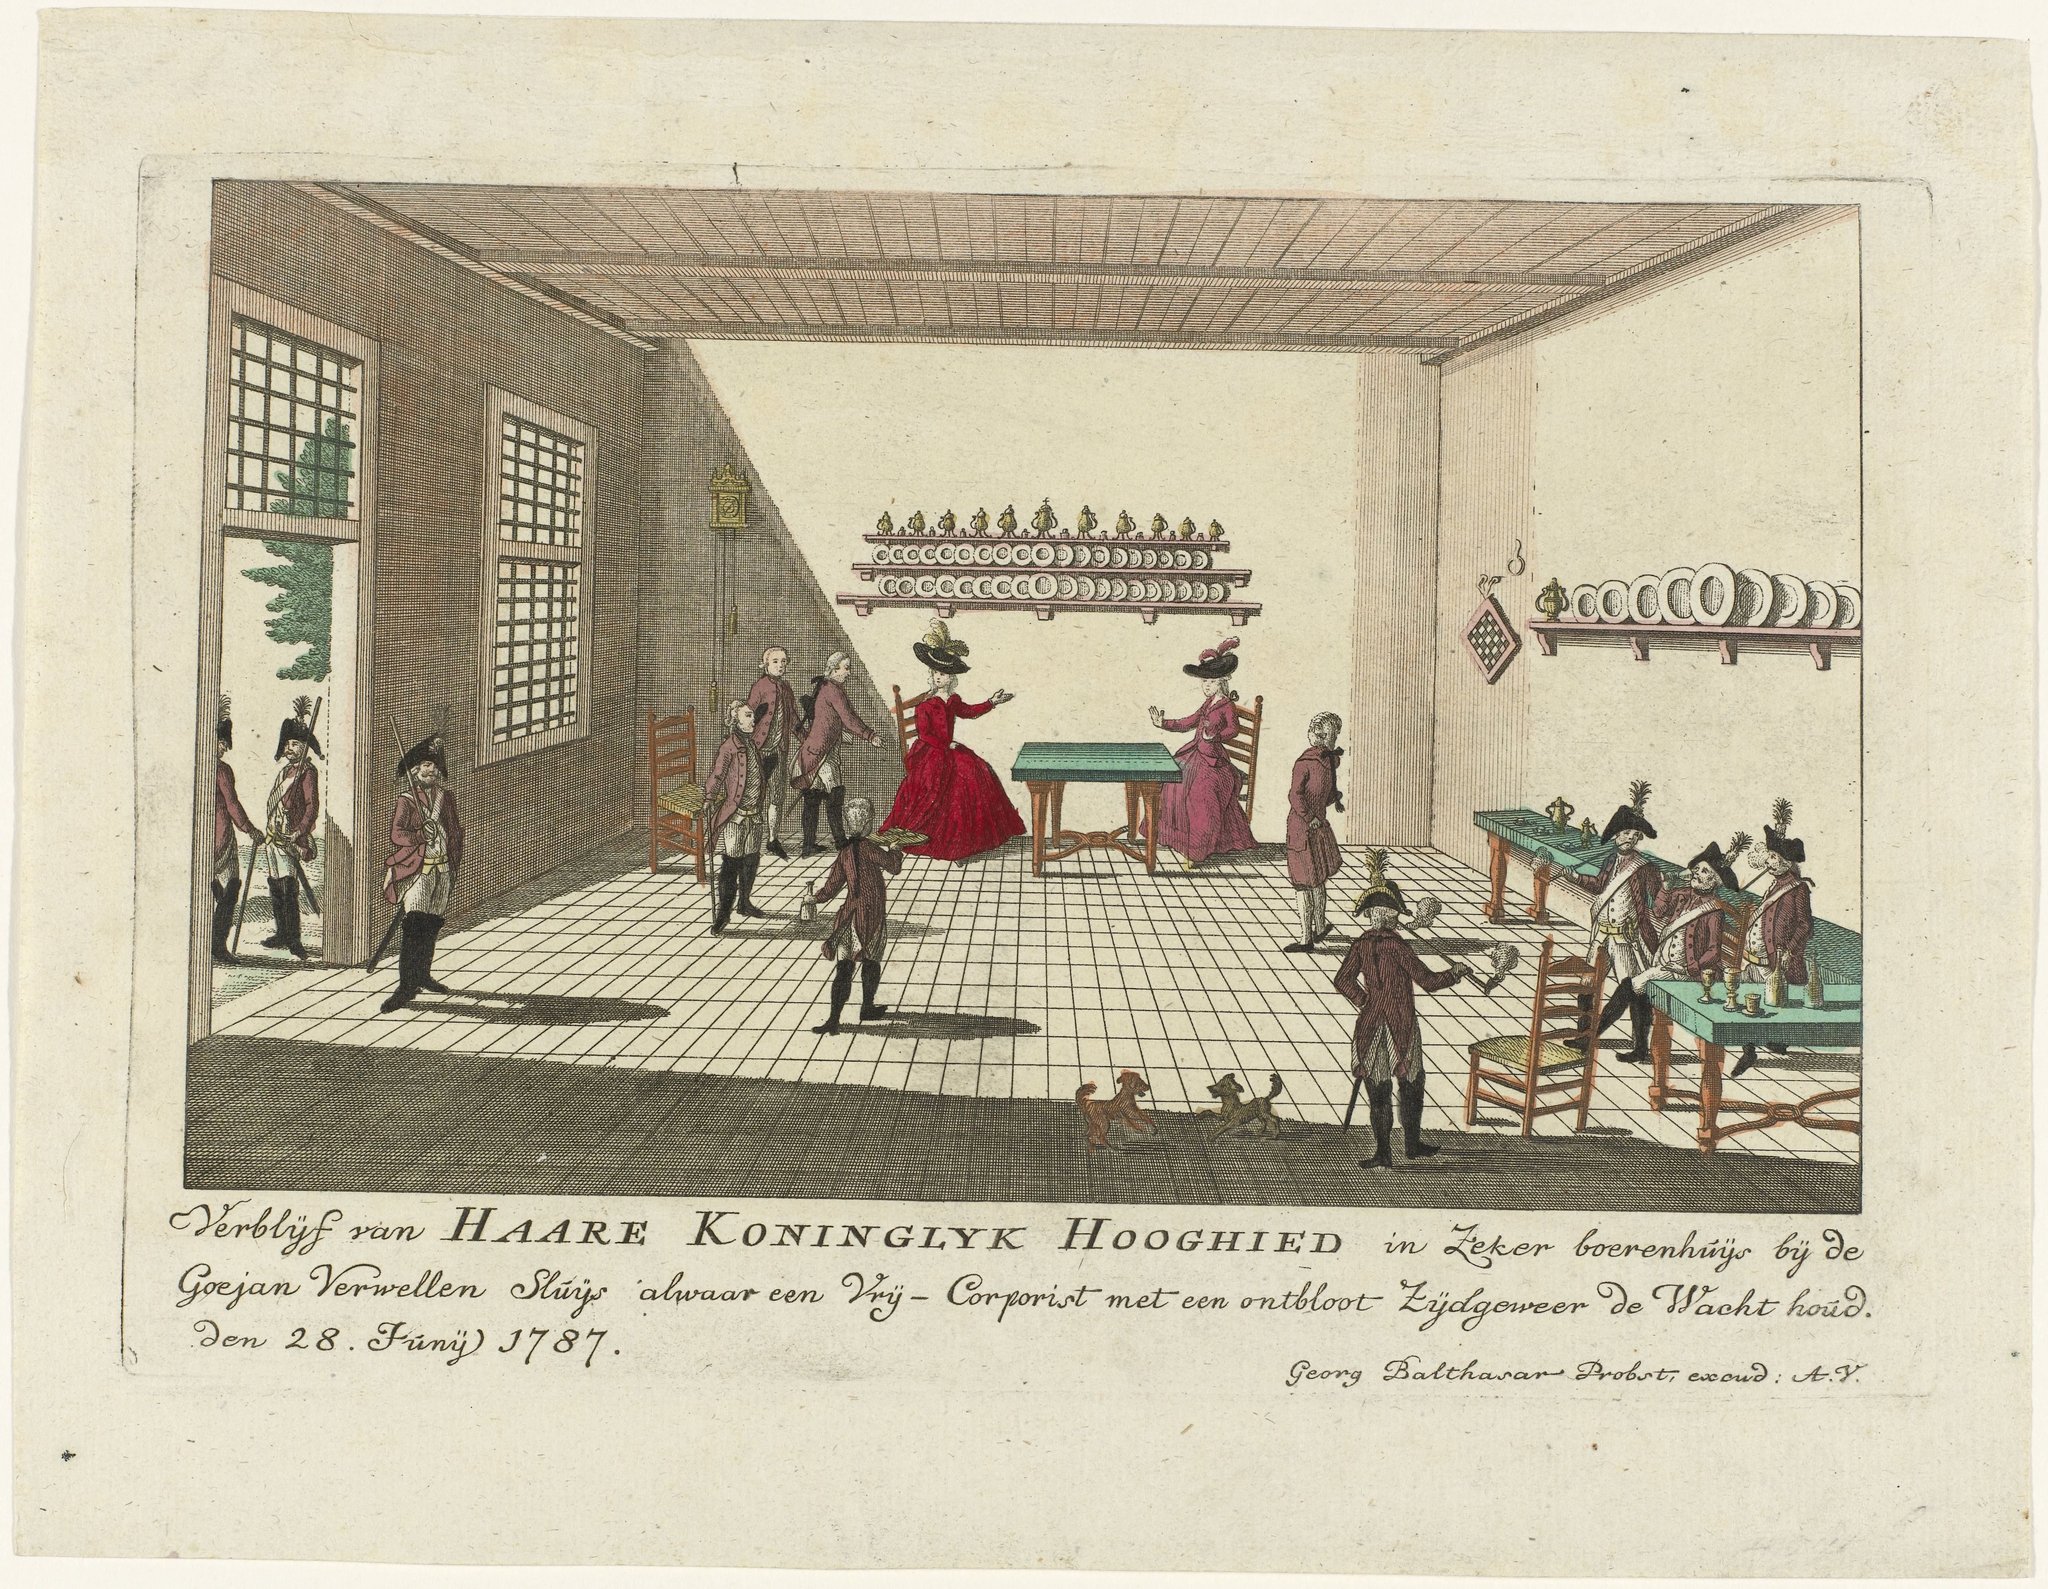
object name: print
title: Ingekleurde Duitse prenten over de gebeurtenissen van 1787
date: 1788-1790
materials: paper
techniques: engraving, etching, hand coloring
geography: augsburg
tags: painter, draughtsman, wilhelmina of prussia (princess of orange), arrest (of criminal)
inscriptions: collector's mark: Lugt 2228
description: Prinses Wilhelmina van Pruisen wordt vastgehouden in de woning te Goejanverwellesluis en bewaakt door rokende en drinkende soldaten, 28 juni 1787. Voor de deur houdt een soldaat van een vrijkorps met ontblote sabel de wacht.